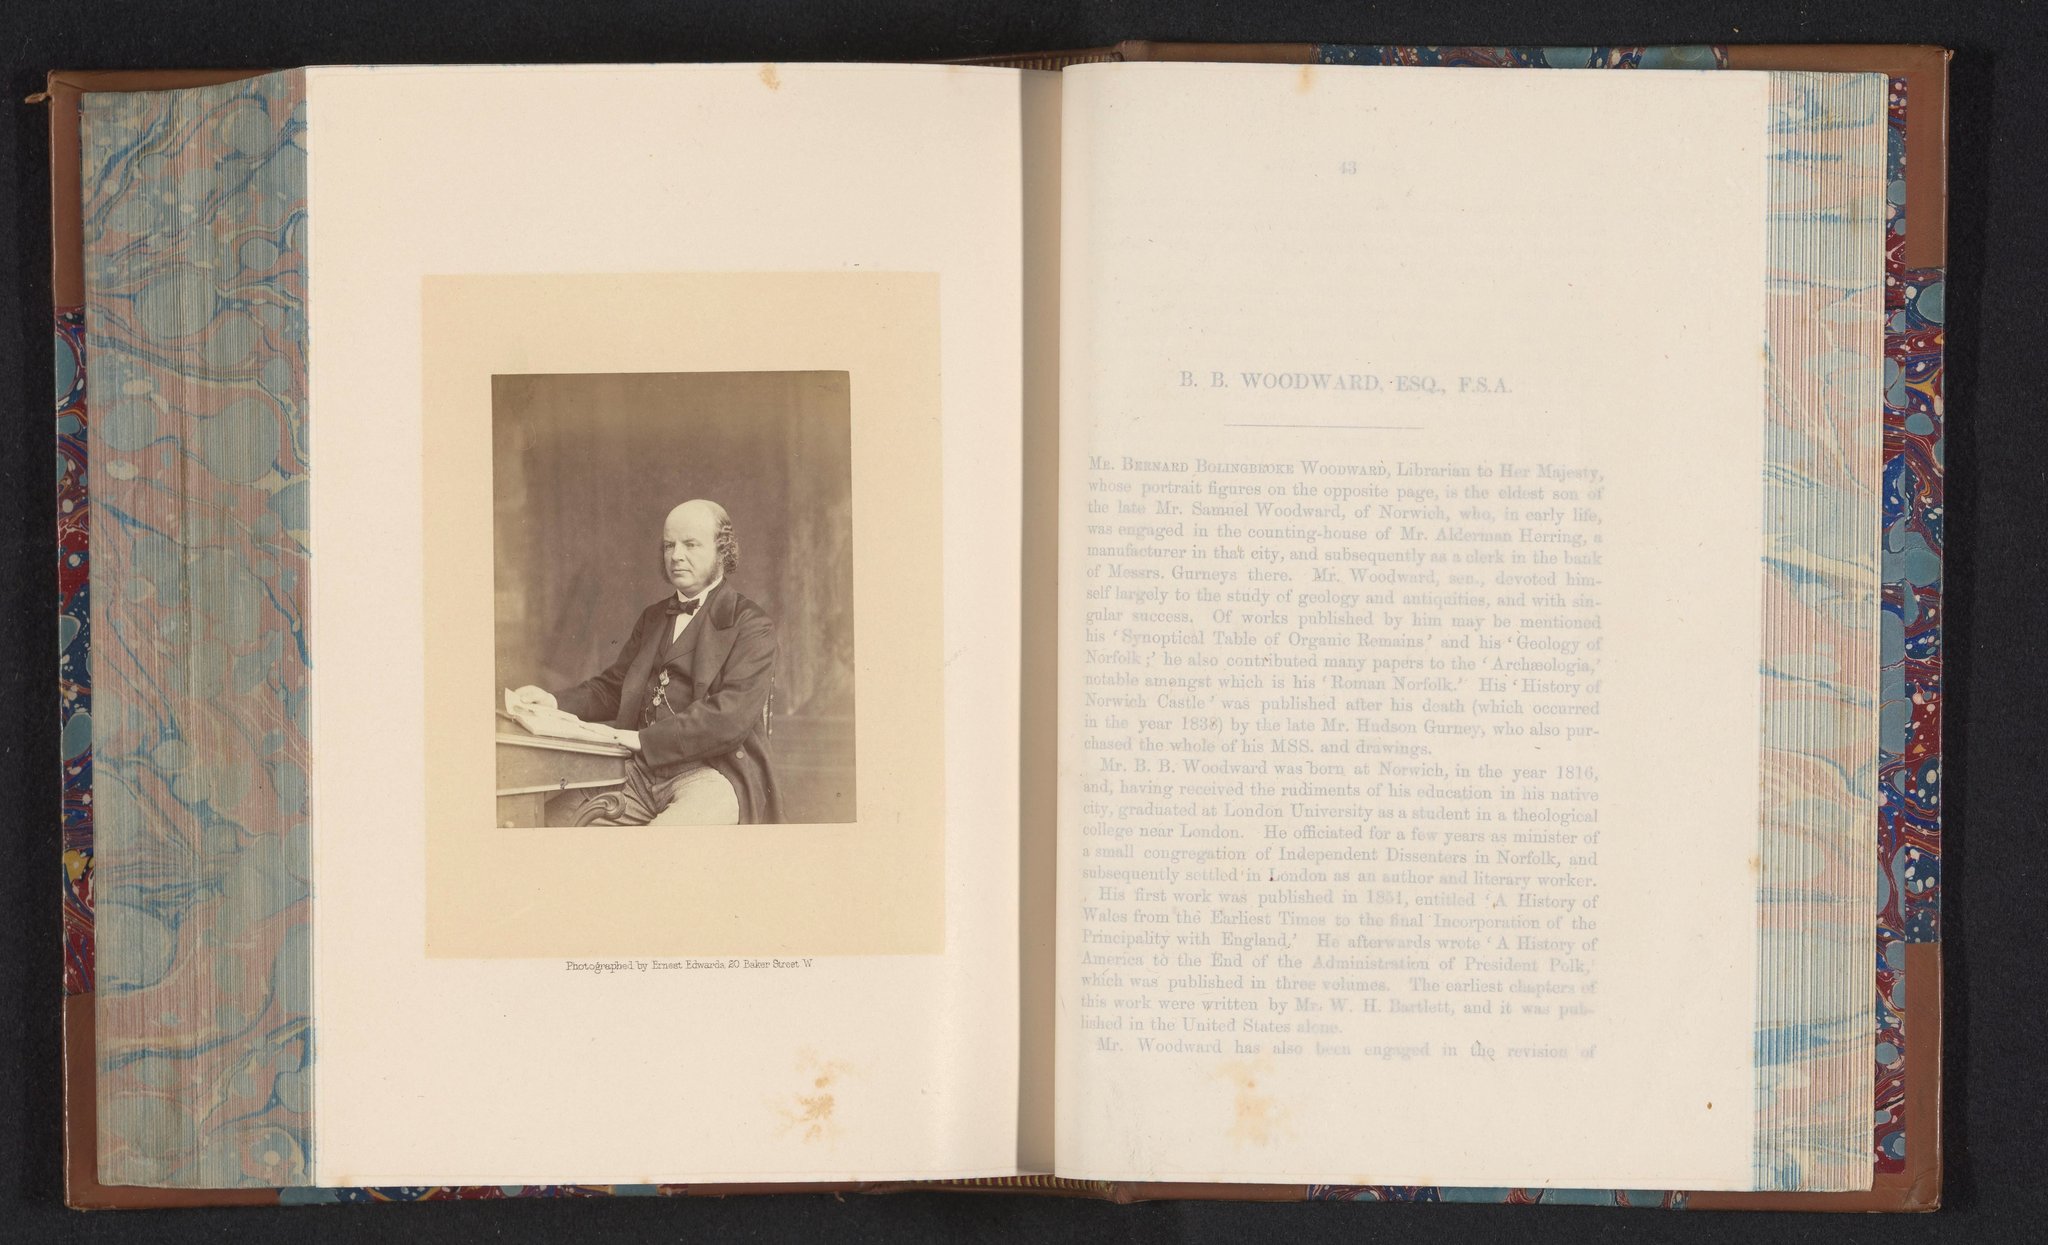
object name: page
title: Portret van Bernard Bolingbroke Woodward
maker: ernest edwards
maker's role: fotograaf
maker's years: 1837-1903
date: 1853-1867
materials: photographic support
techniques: albumen print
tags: minister ~ government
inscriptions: name: ‘Photographed by Ernest Edwards, 20, Baker Street. W.’